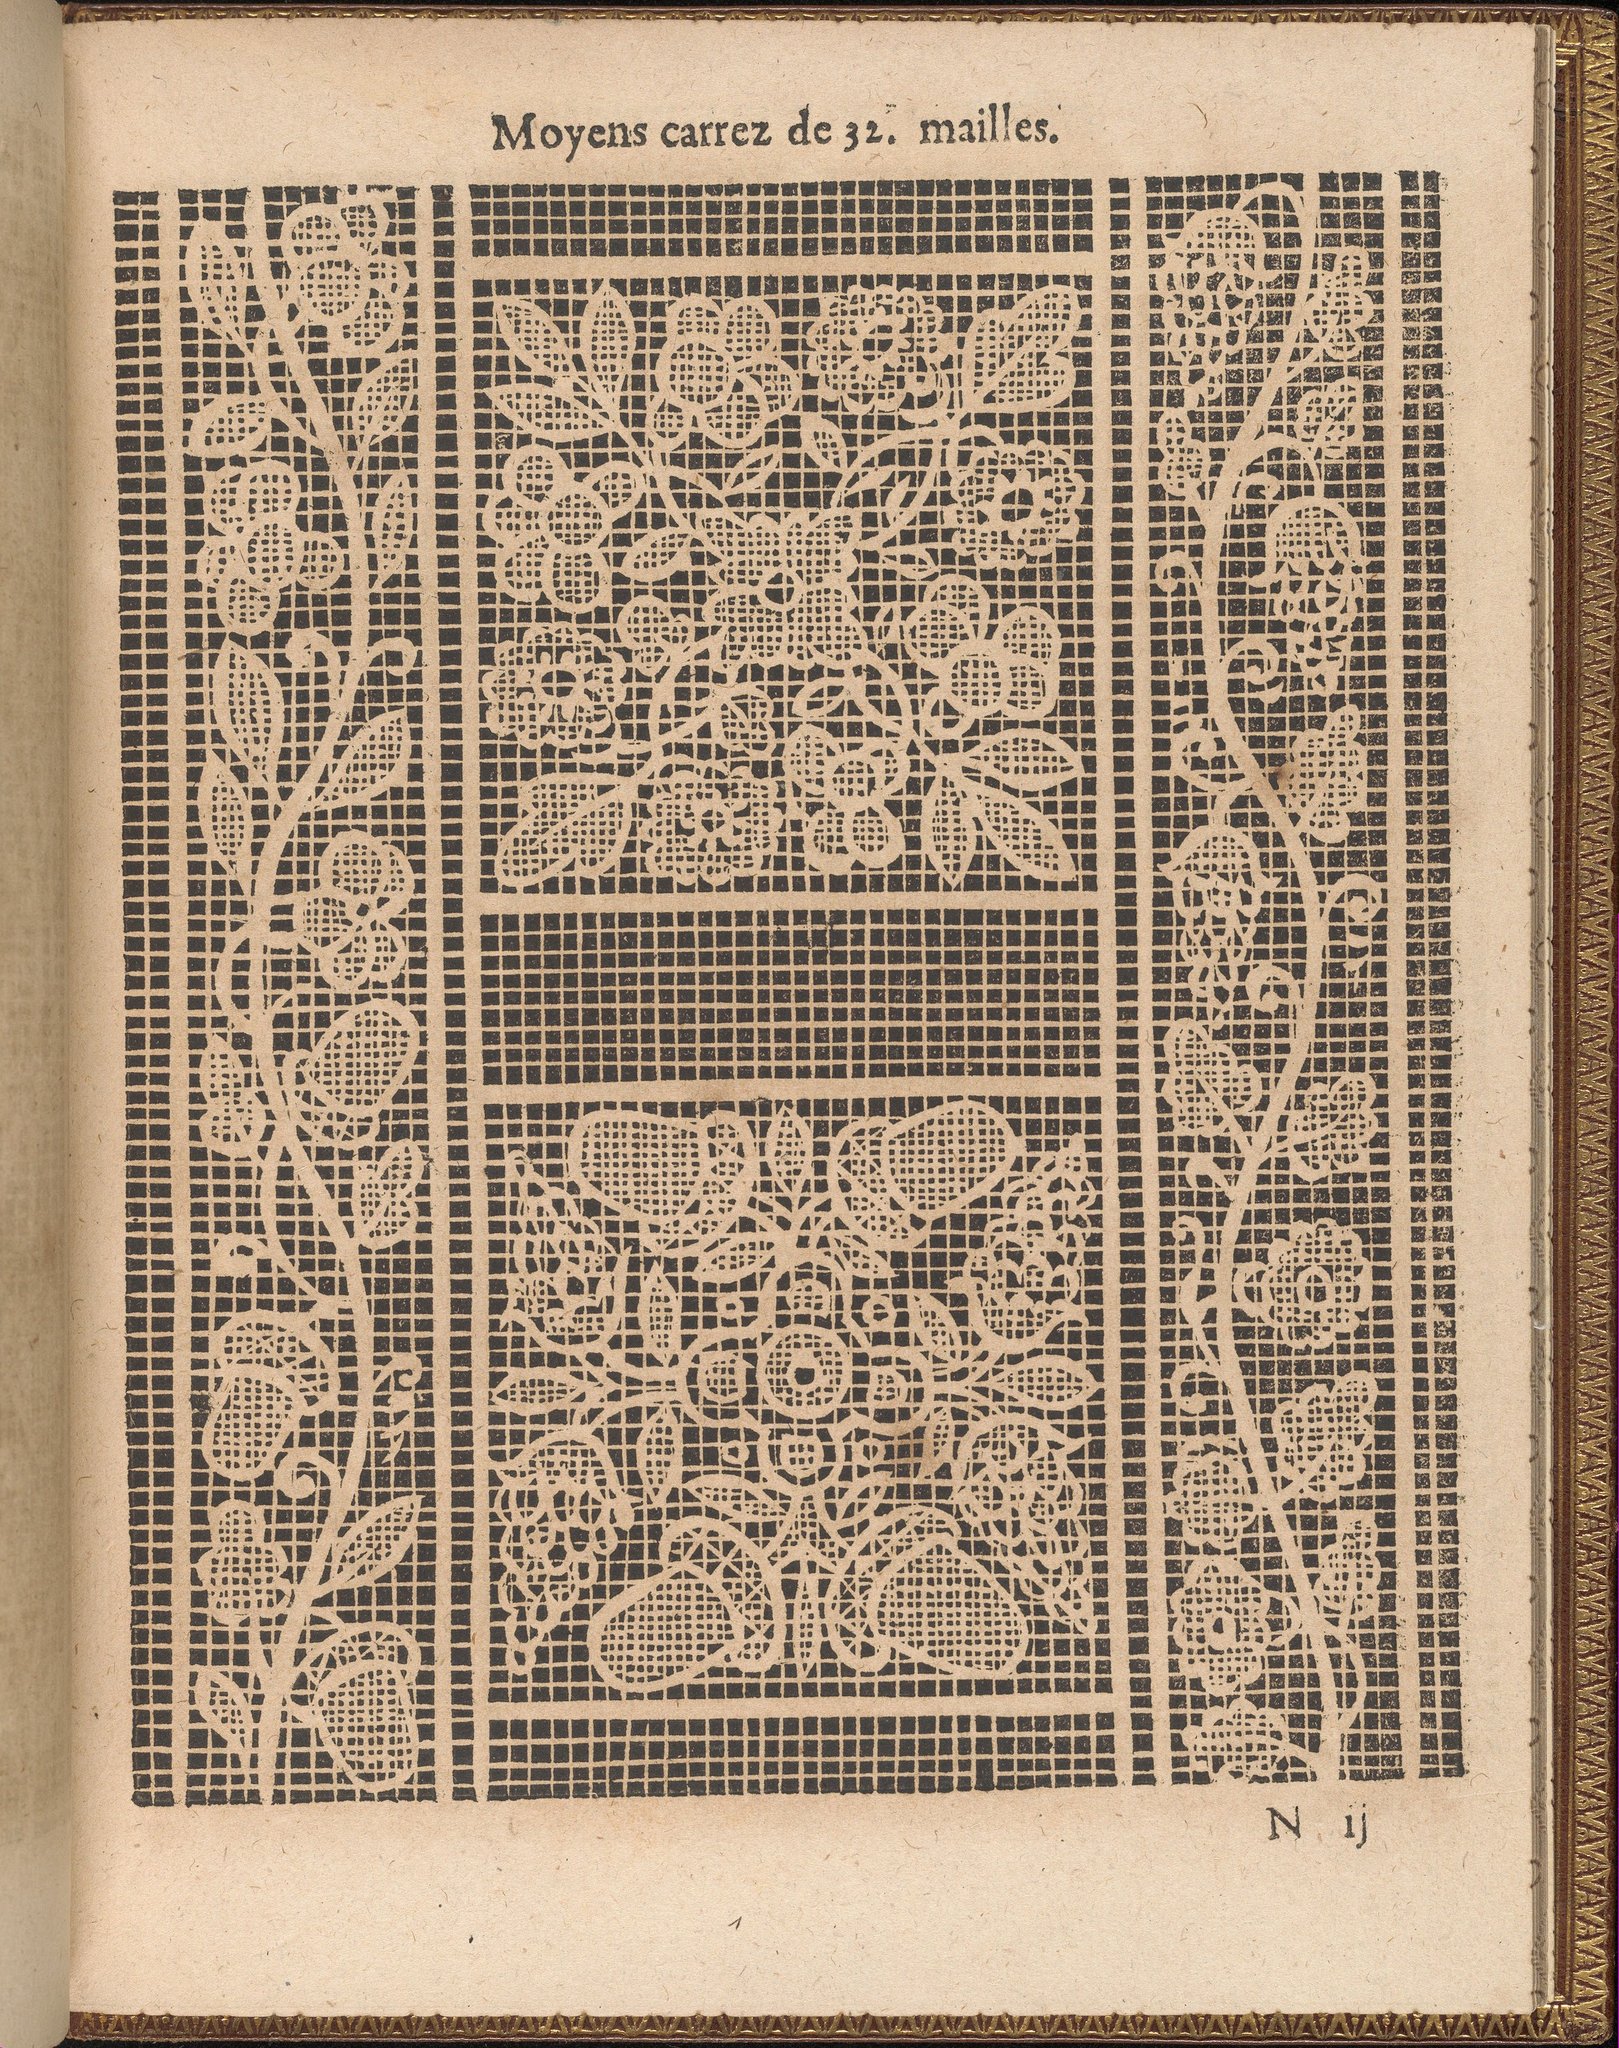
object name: book print ornament architecture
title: La Pratique de l'Aiguille, page 49 (recto)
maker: matthias mignerak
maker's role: author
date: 1605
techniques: woodcut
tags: ornament